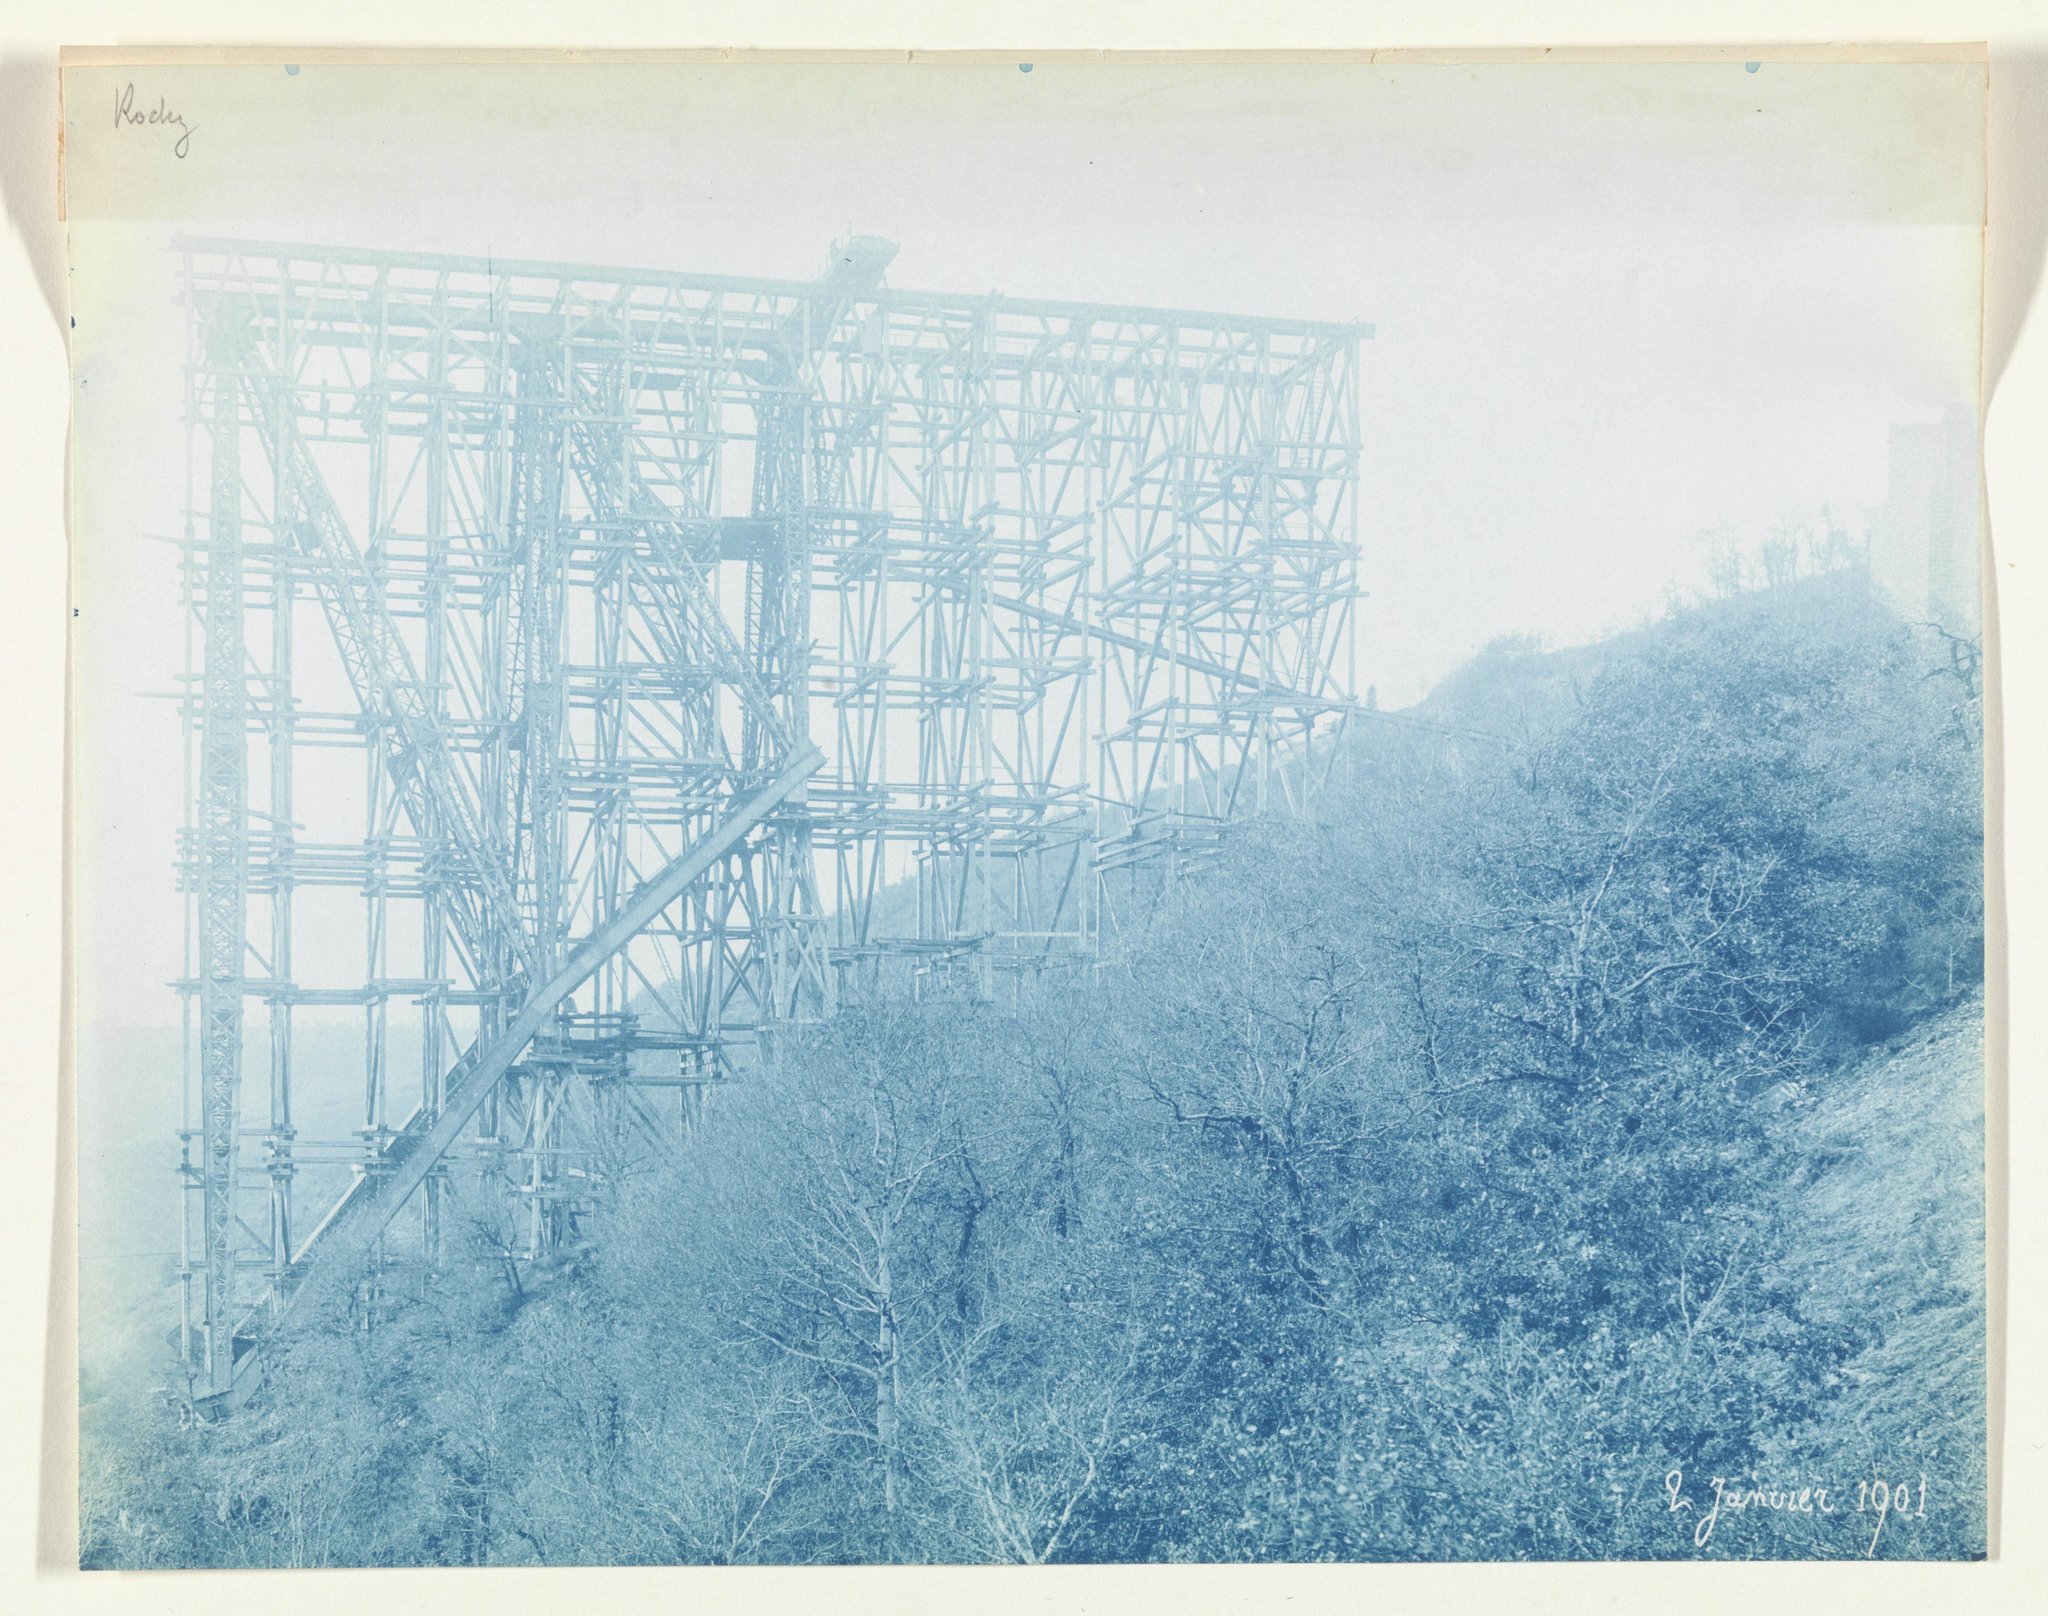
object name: photograph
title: Aanleg van het Viaur Viaduct in Frankrijk door de Societé de Construction des Battignolles, 2 januari 1901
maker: Anonymous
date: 1901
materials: photographic support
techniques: cyanotype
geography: france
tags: viaduct, making the overground structures (~ building activities)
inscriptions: inscription: ‘Rodez’